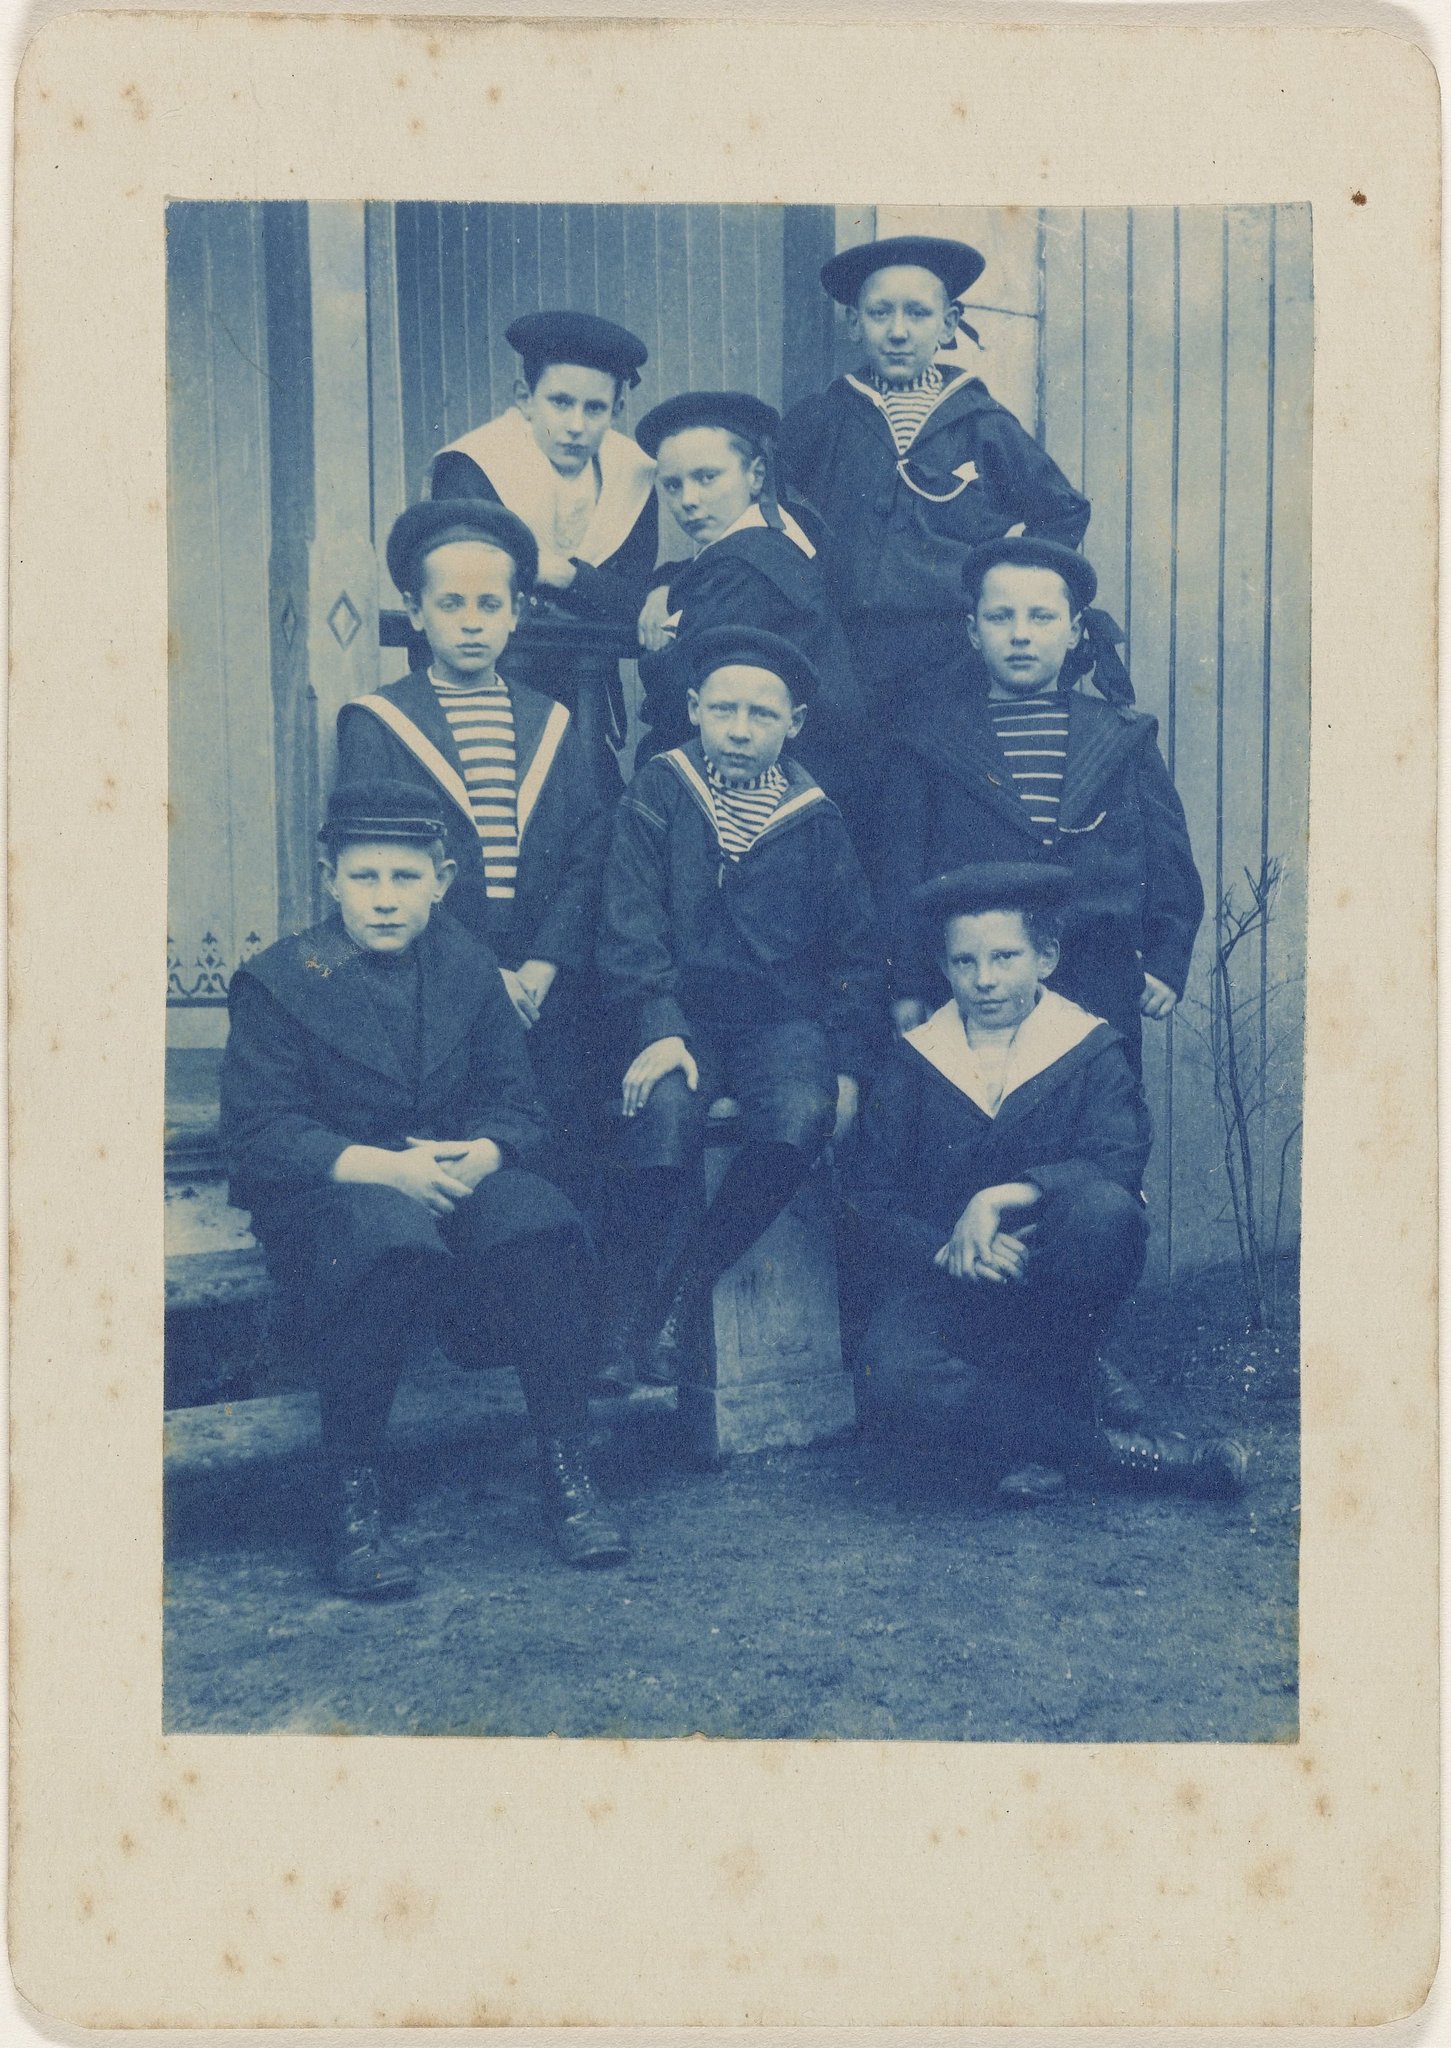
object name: photograph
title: Groepsportret van acht onbekende jongens, onder wie Scato Fontein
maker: frits freerks fontein fz.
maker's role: fotograaf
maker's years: 1882-1928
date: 1895-1900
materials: cardboard, paper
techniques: cyanotype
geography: netherlands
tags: harlingen, historical person (with name) - historical person (with name) portrayed in a group, in a group-portrait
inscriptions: inscription: ‘Scato met vriendjes’, stamp: ‘F. Fontein Fzn.’